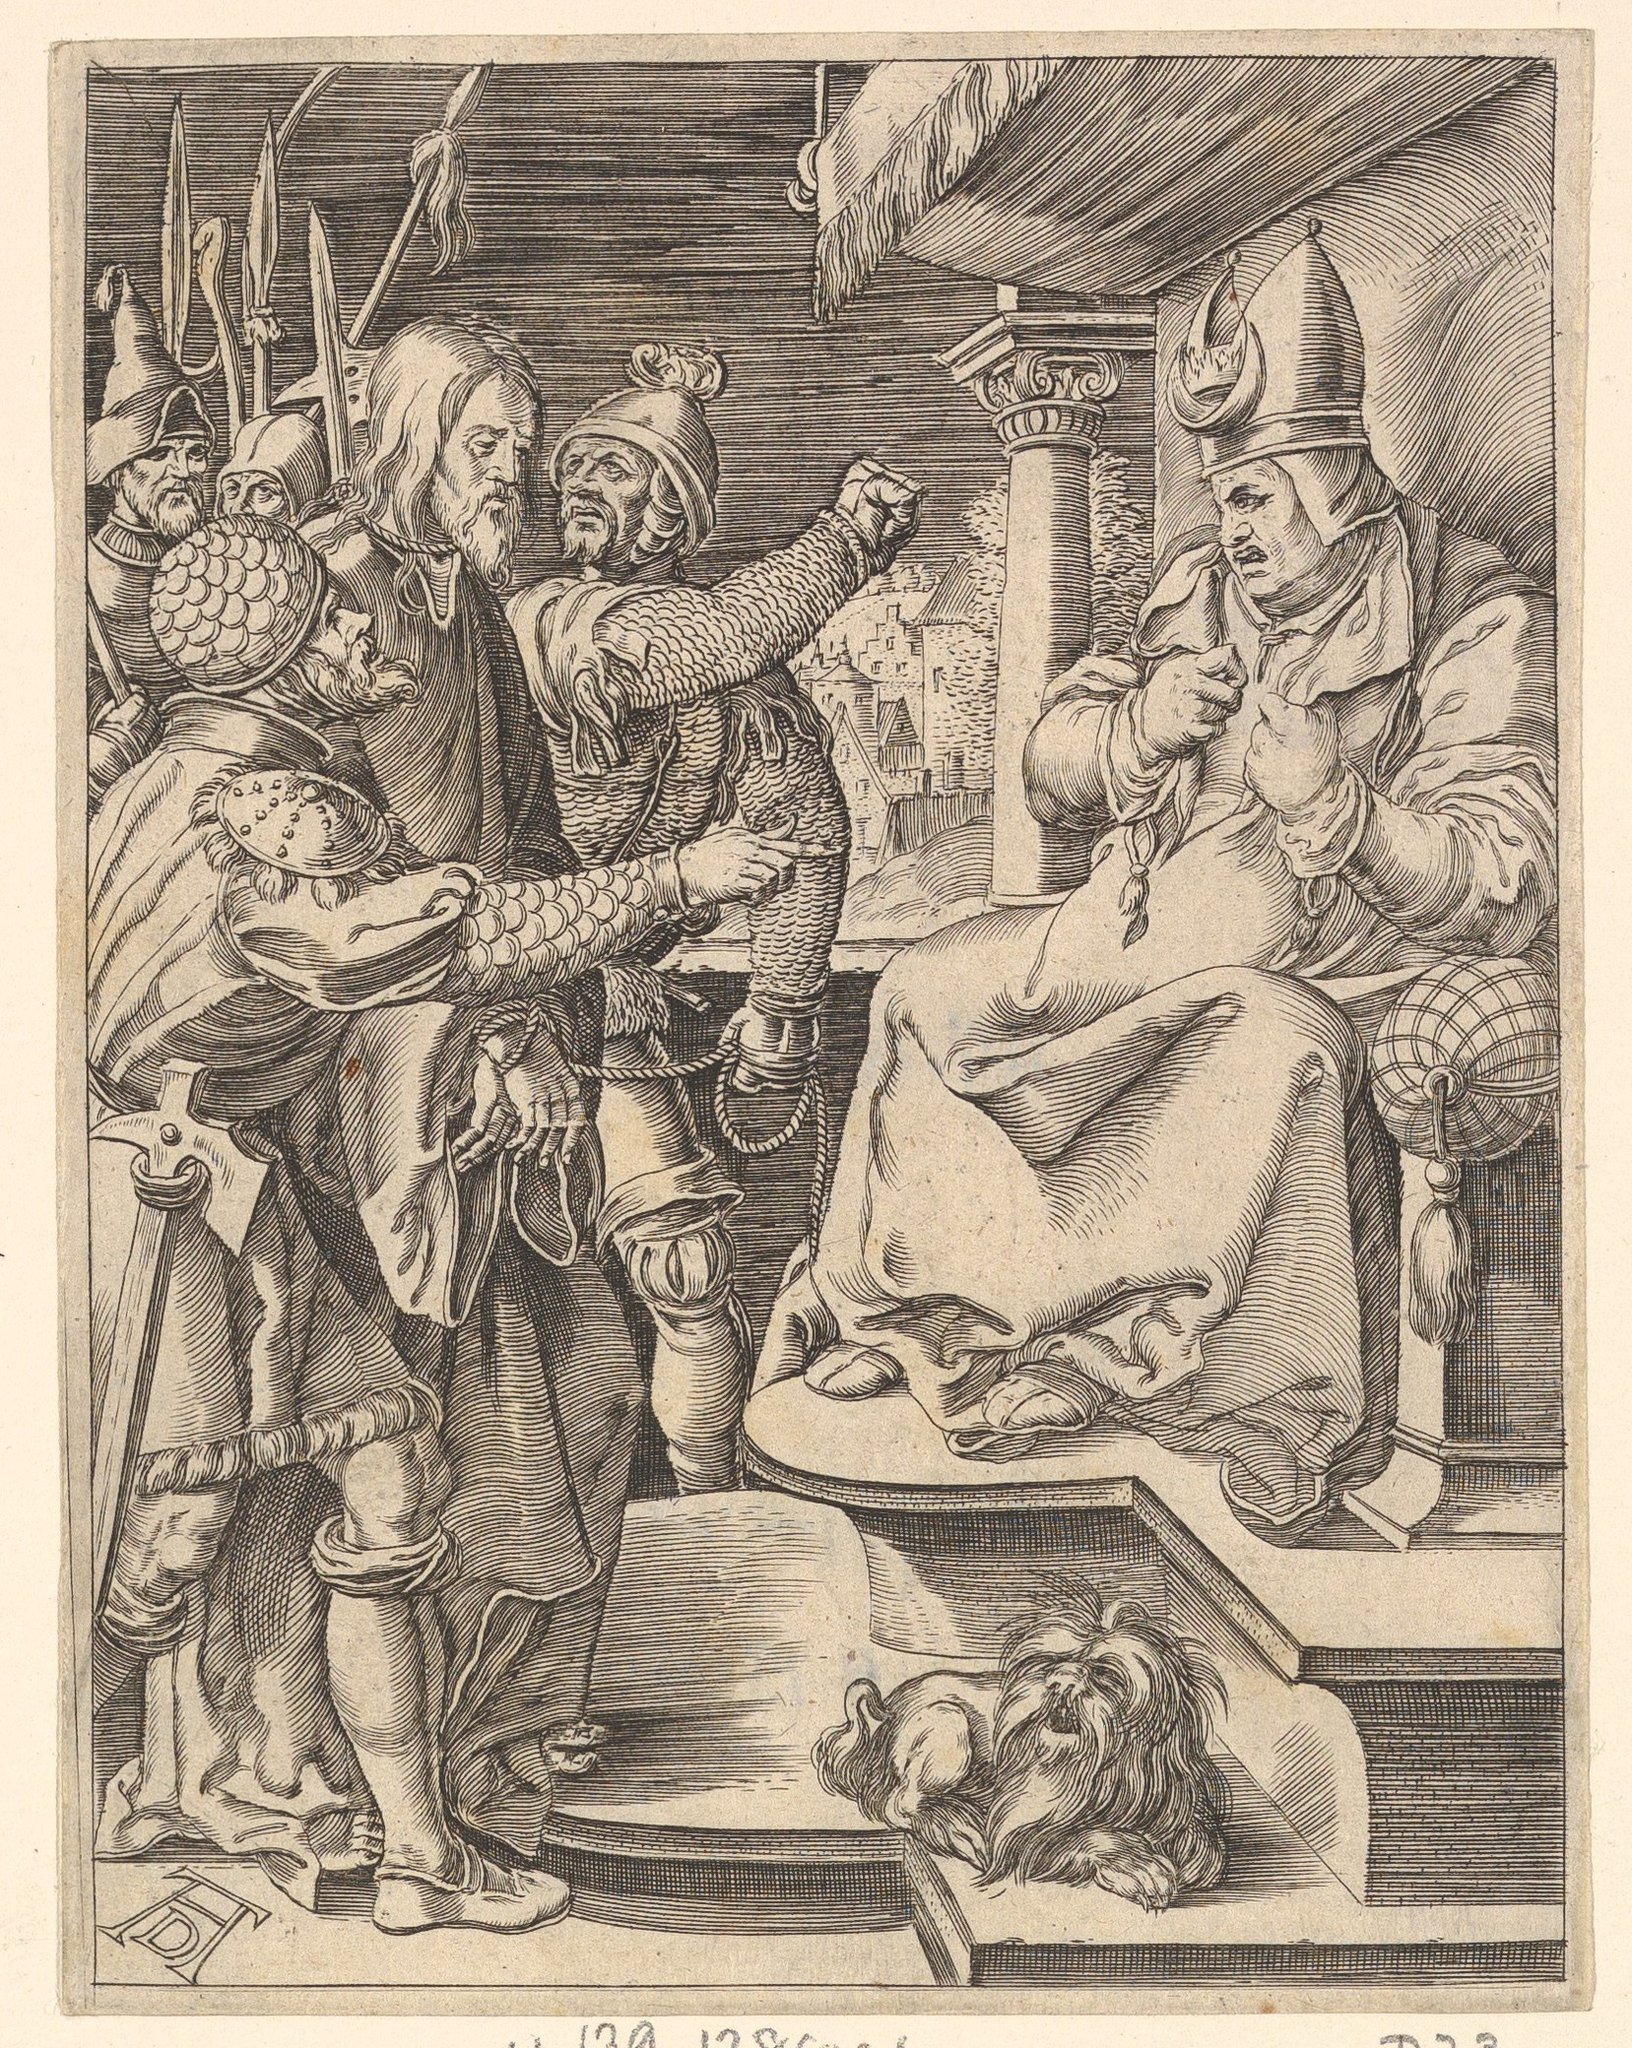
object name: print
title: Engraved copies of The Little Passion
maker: albrecht dürer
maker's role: artist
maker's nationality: german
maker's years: 1471-1528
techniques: engraving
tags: soldiers,spears,men,dogs,christ